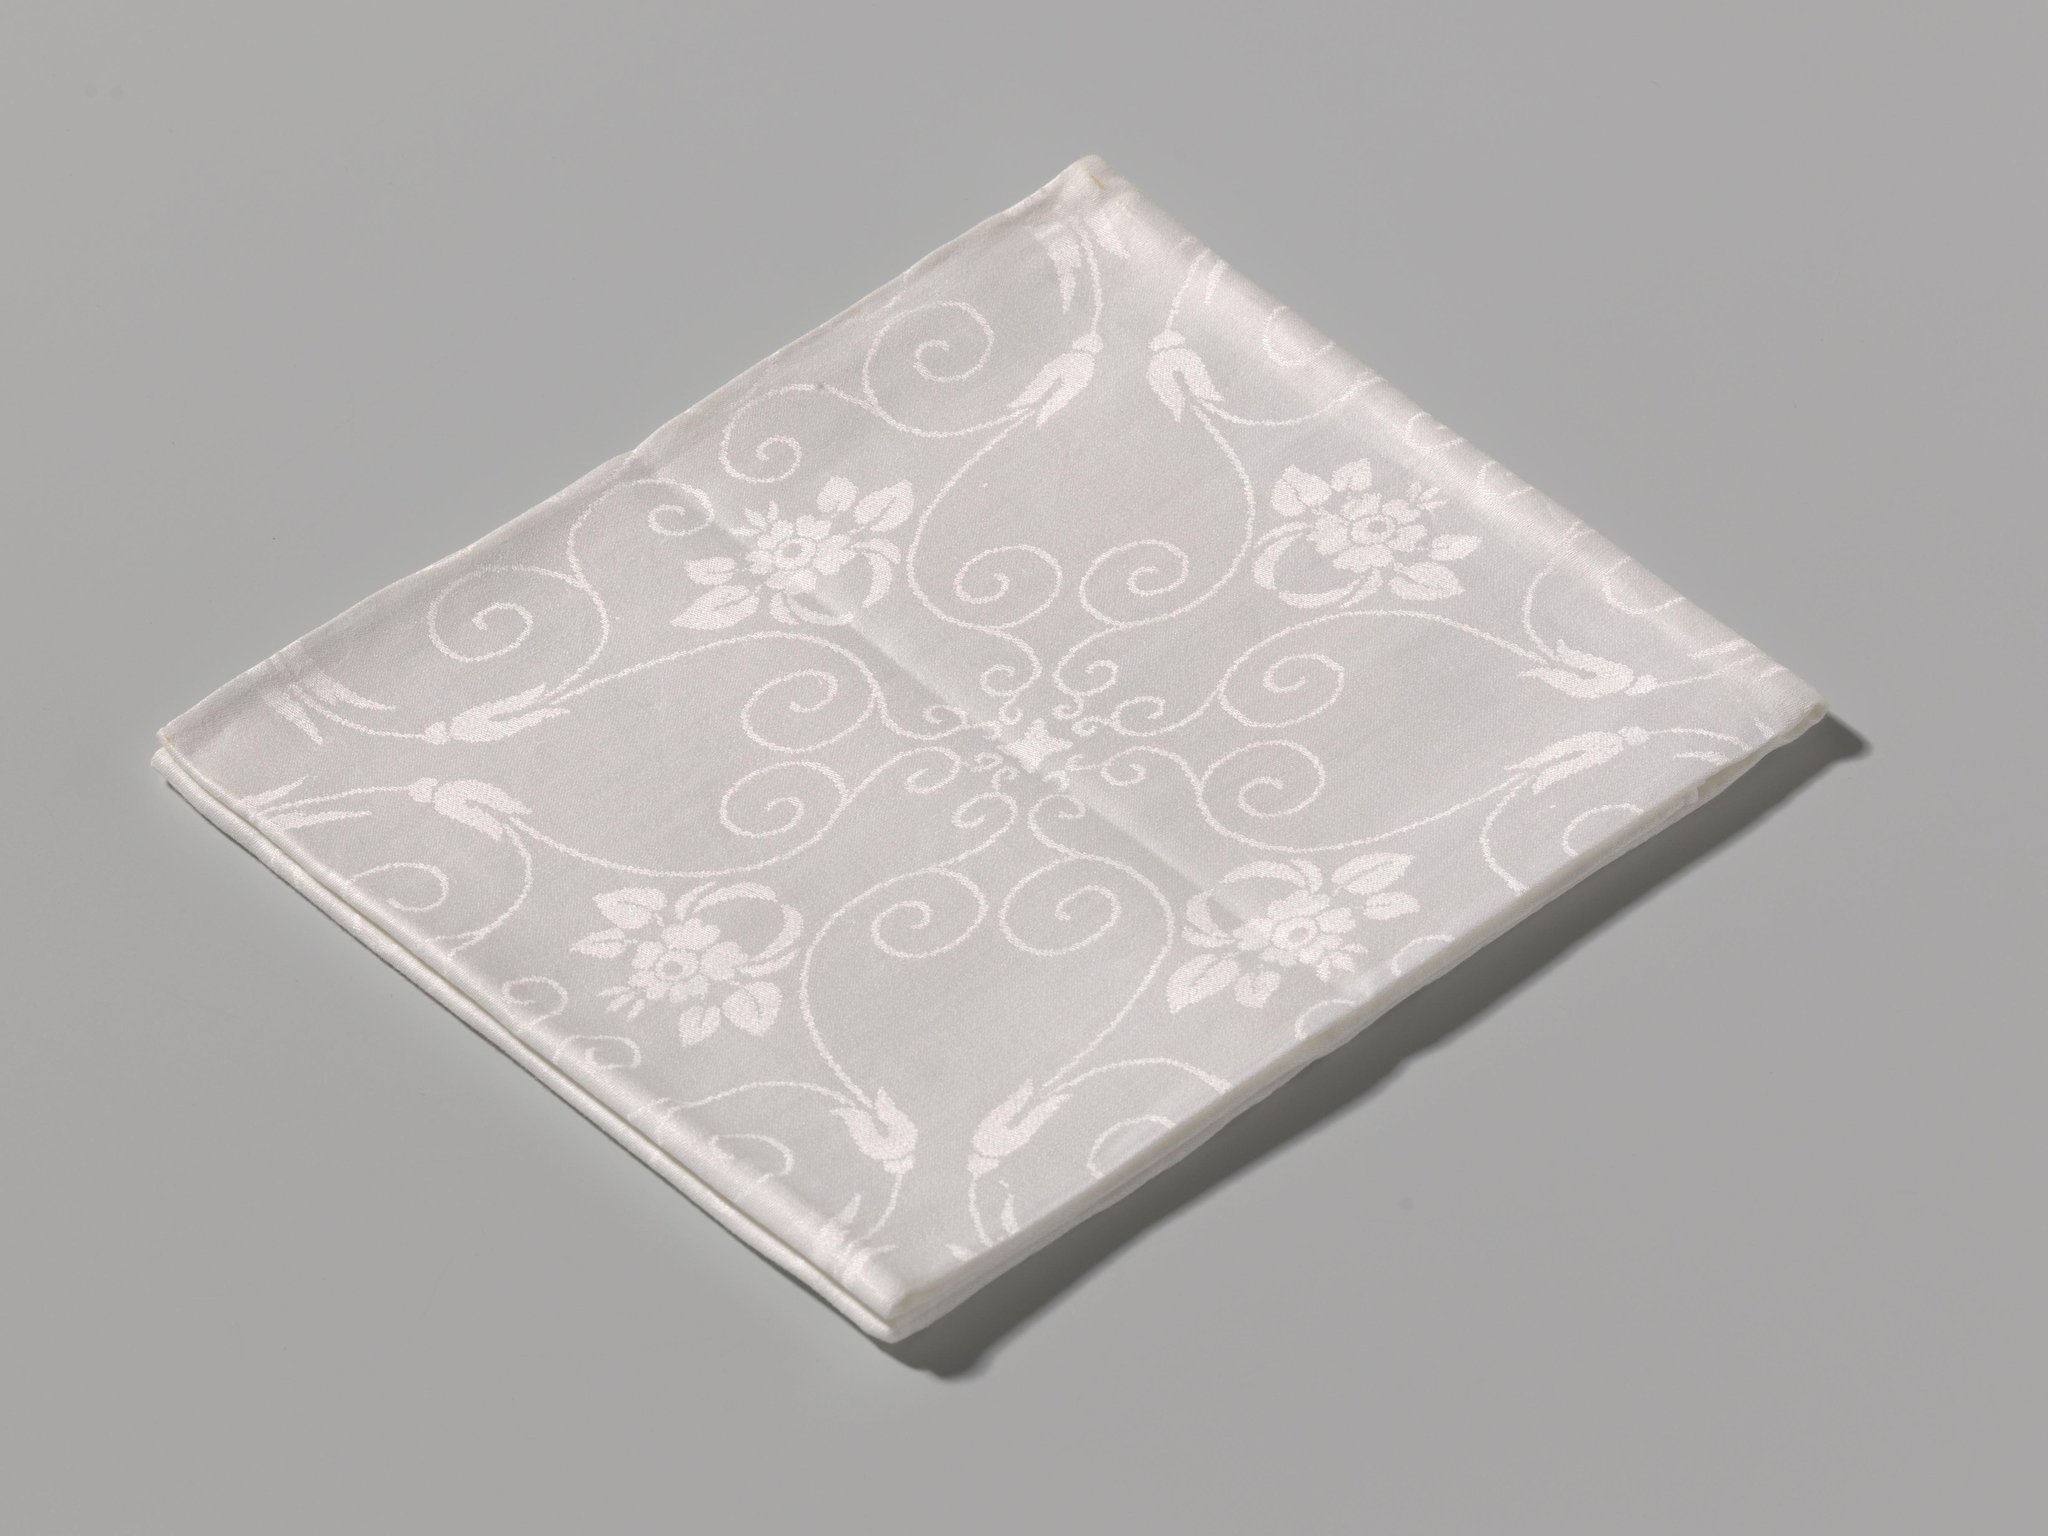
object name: napkin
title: Servet met patroon van ranken en de inweving JD (Jiskoot-Dwars).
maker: Anonymous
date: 1879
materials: linen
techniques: damask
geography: netherlands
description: Wit linnen damasten servet met een patroon van ranken en de inweving "JD" (Jiskoot-Dwars).